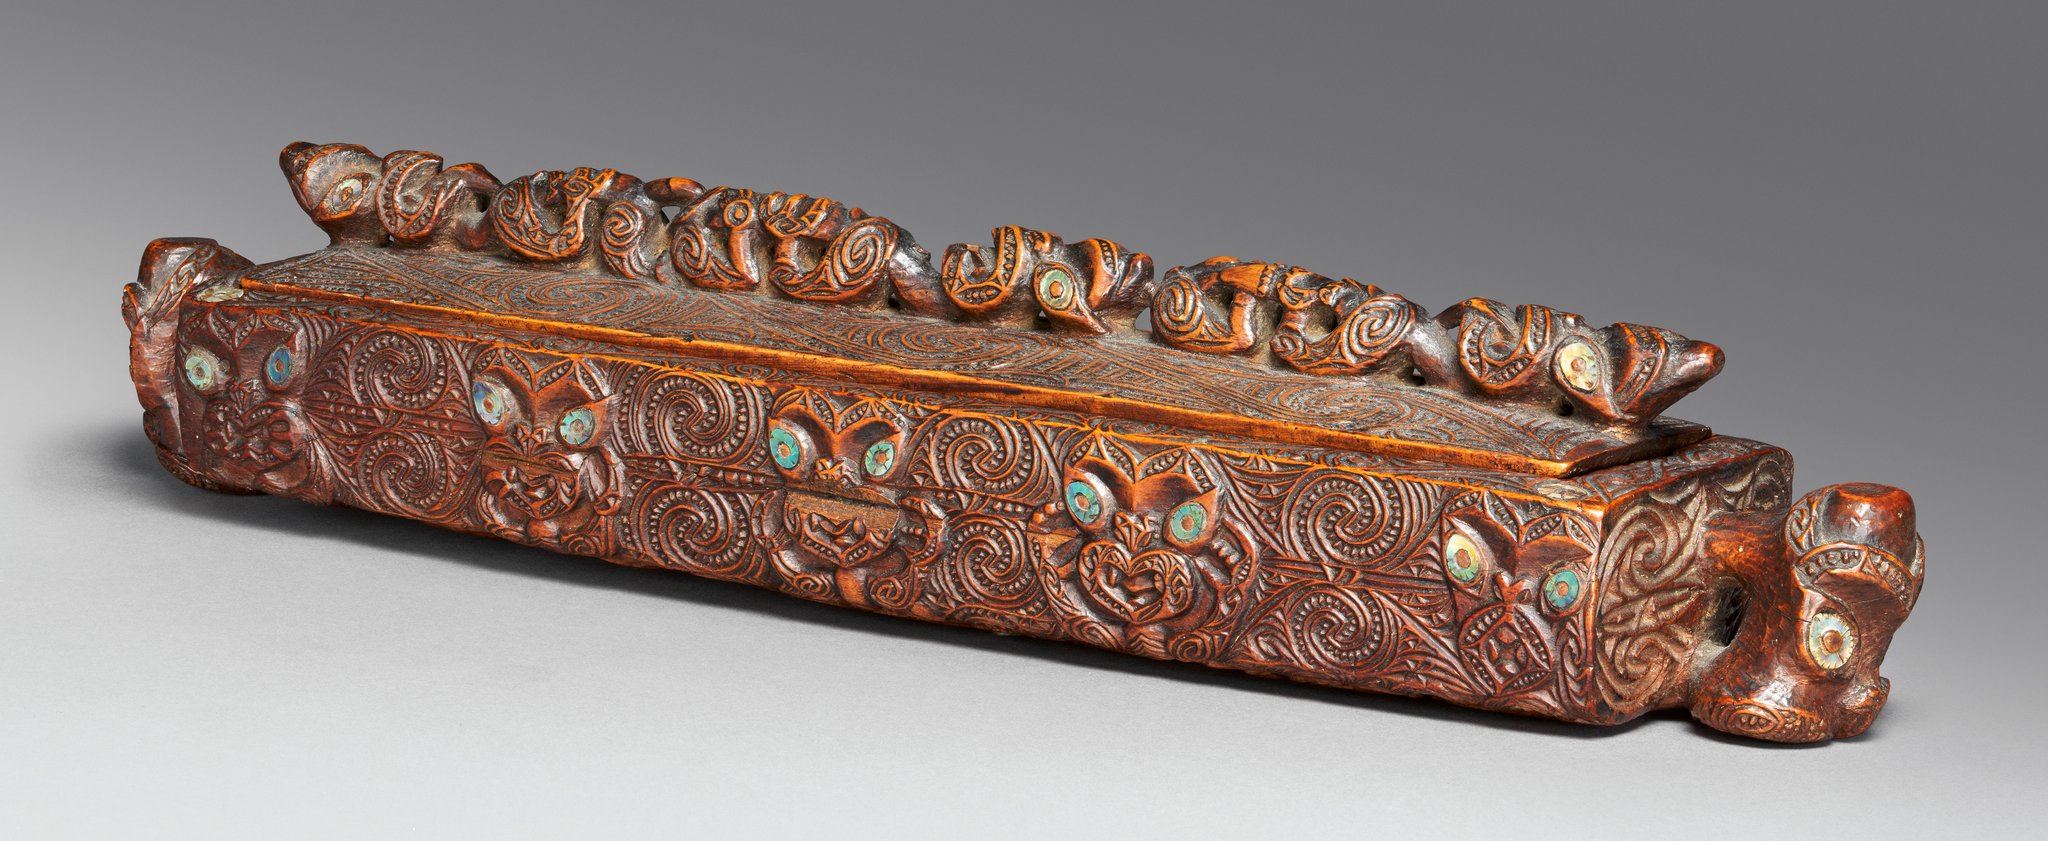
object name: box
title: Treasure Box (Papahou)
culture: maori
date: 1701-1800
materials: shell, wood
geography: new zealand